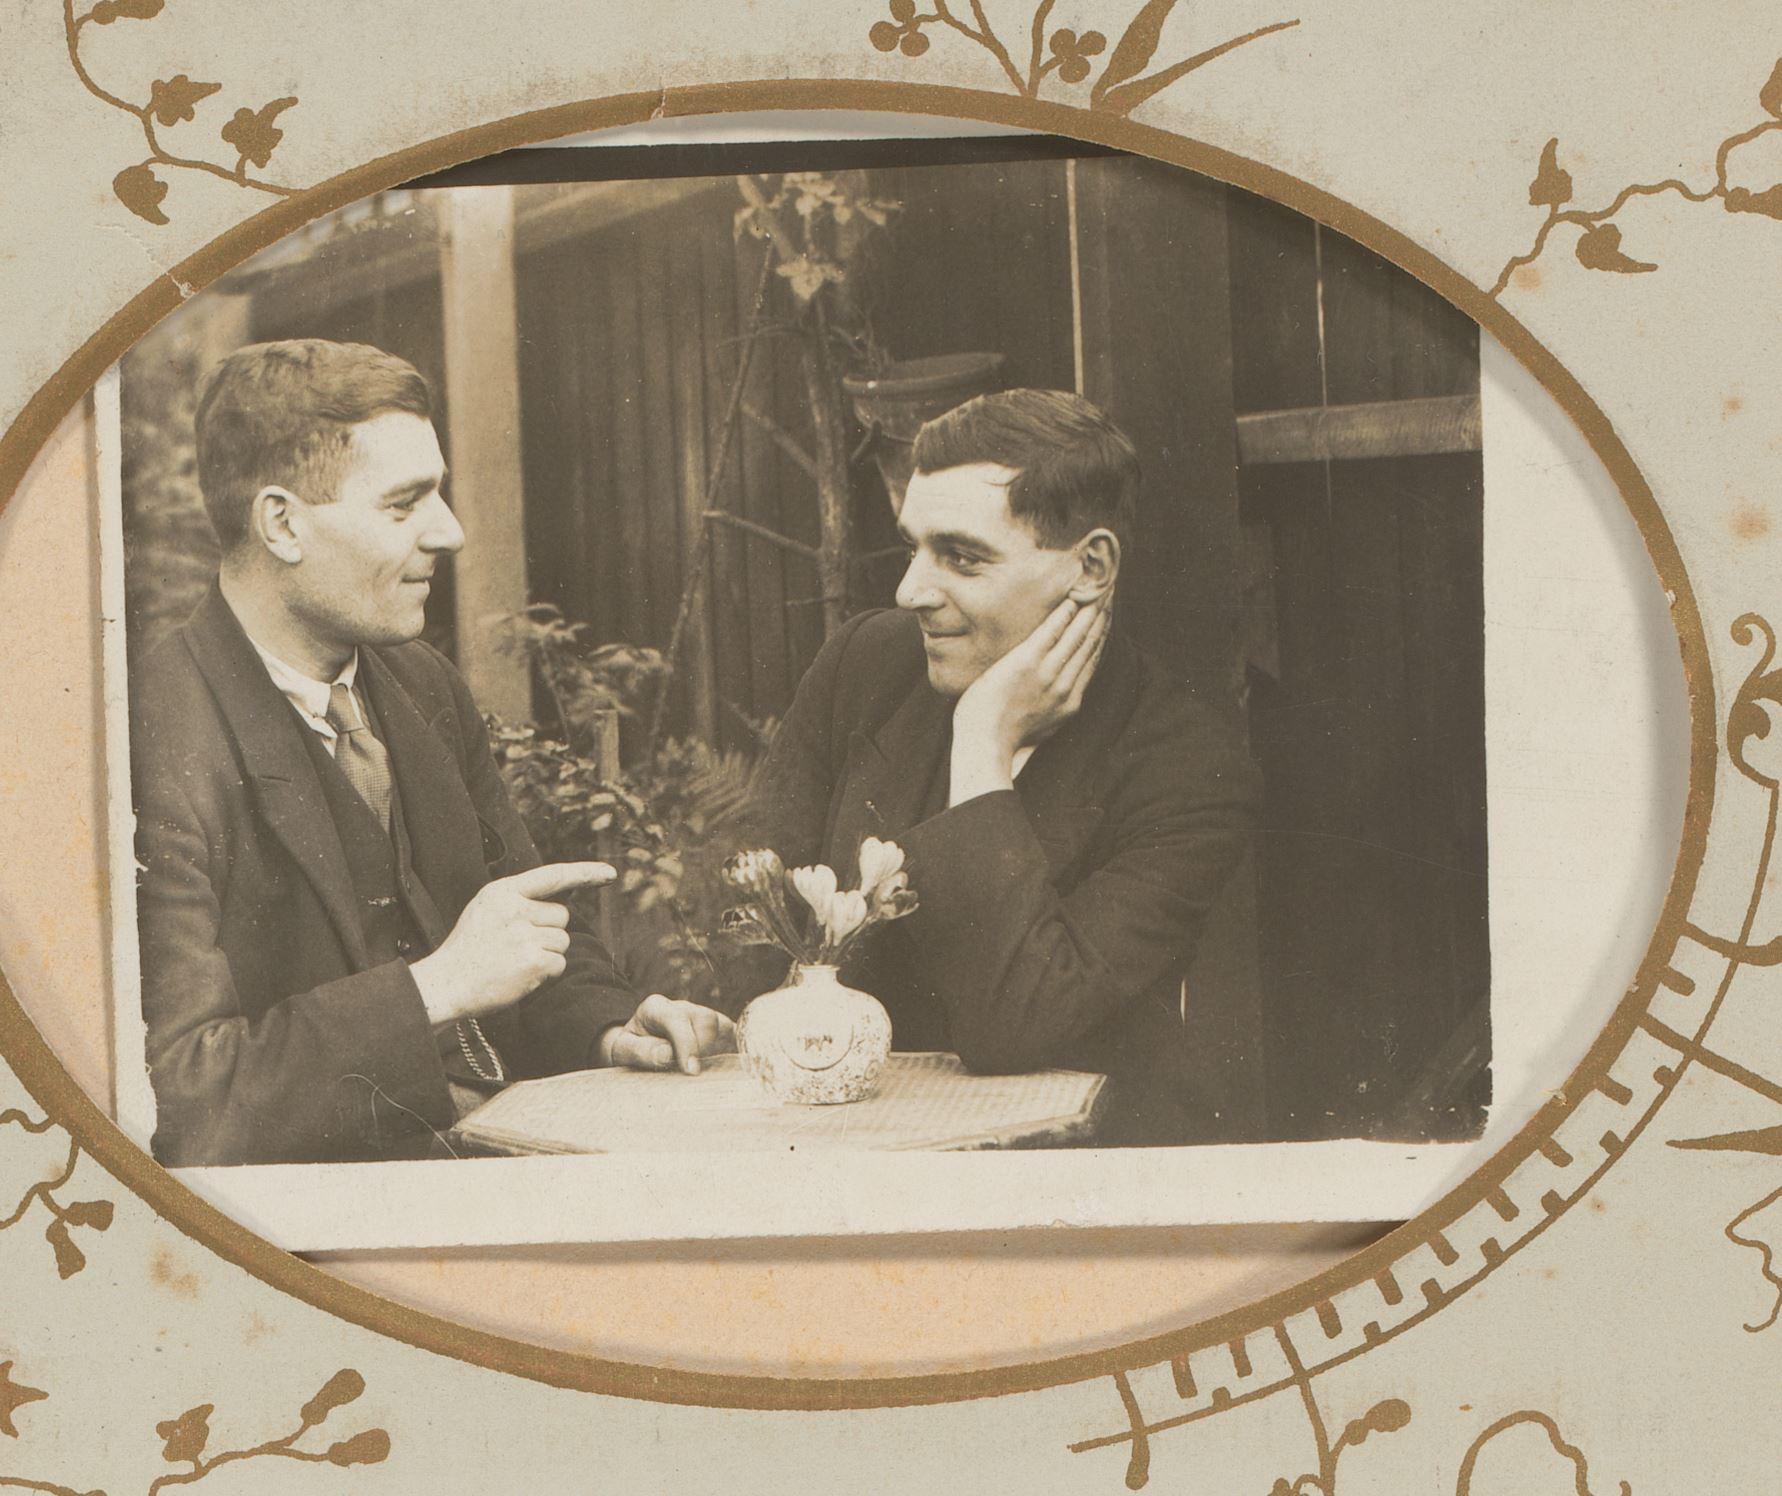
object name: photograph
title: Twee mannen in gesprek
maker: Anonymous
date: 1899-1940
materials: photographic support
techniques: gelatin silver print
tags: adult man, historical persons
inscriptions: inscription: ‘Post card/correspondence/ address’